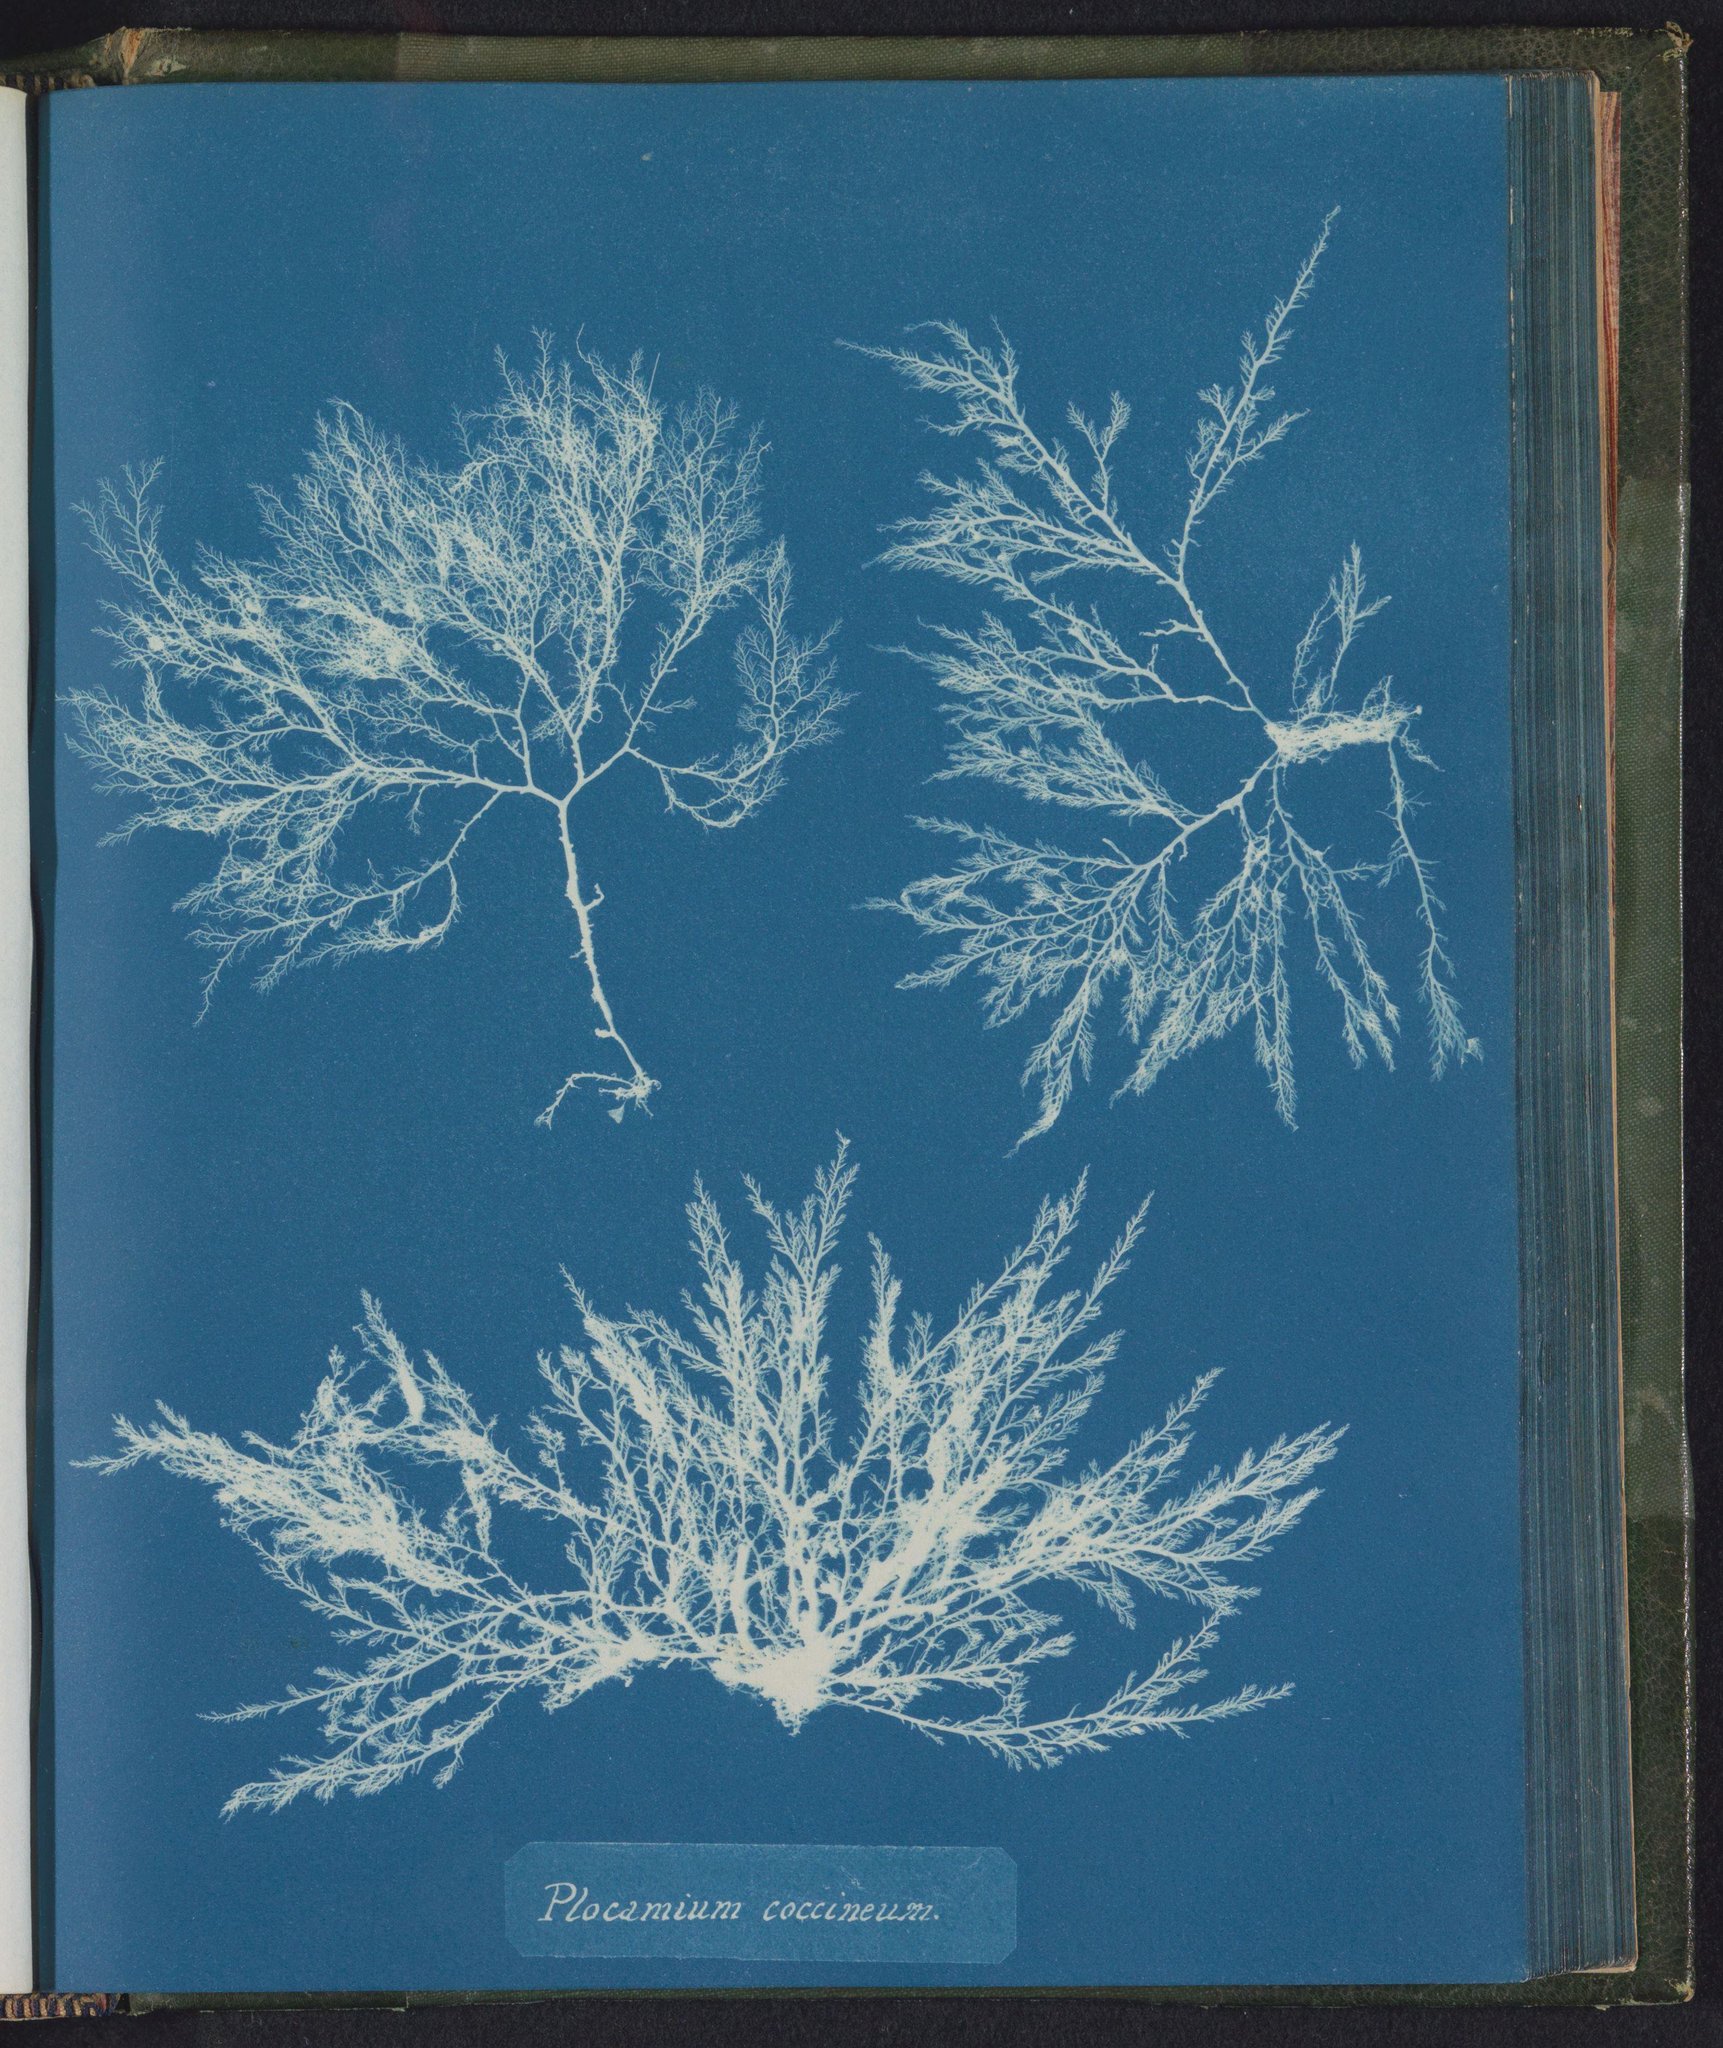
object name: page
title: Zeewier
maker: anna atkins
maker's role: fotograaf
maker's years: 1799-1871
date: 1843-1853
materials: photographic support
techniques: cyanotype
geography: united kingdom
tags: algae, seaweed